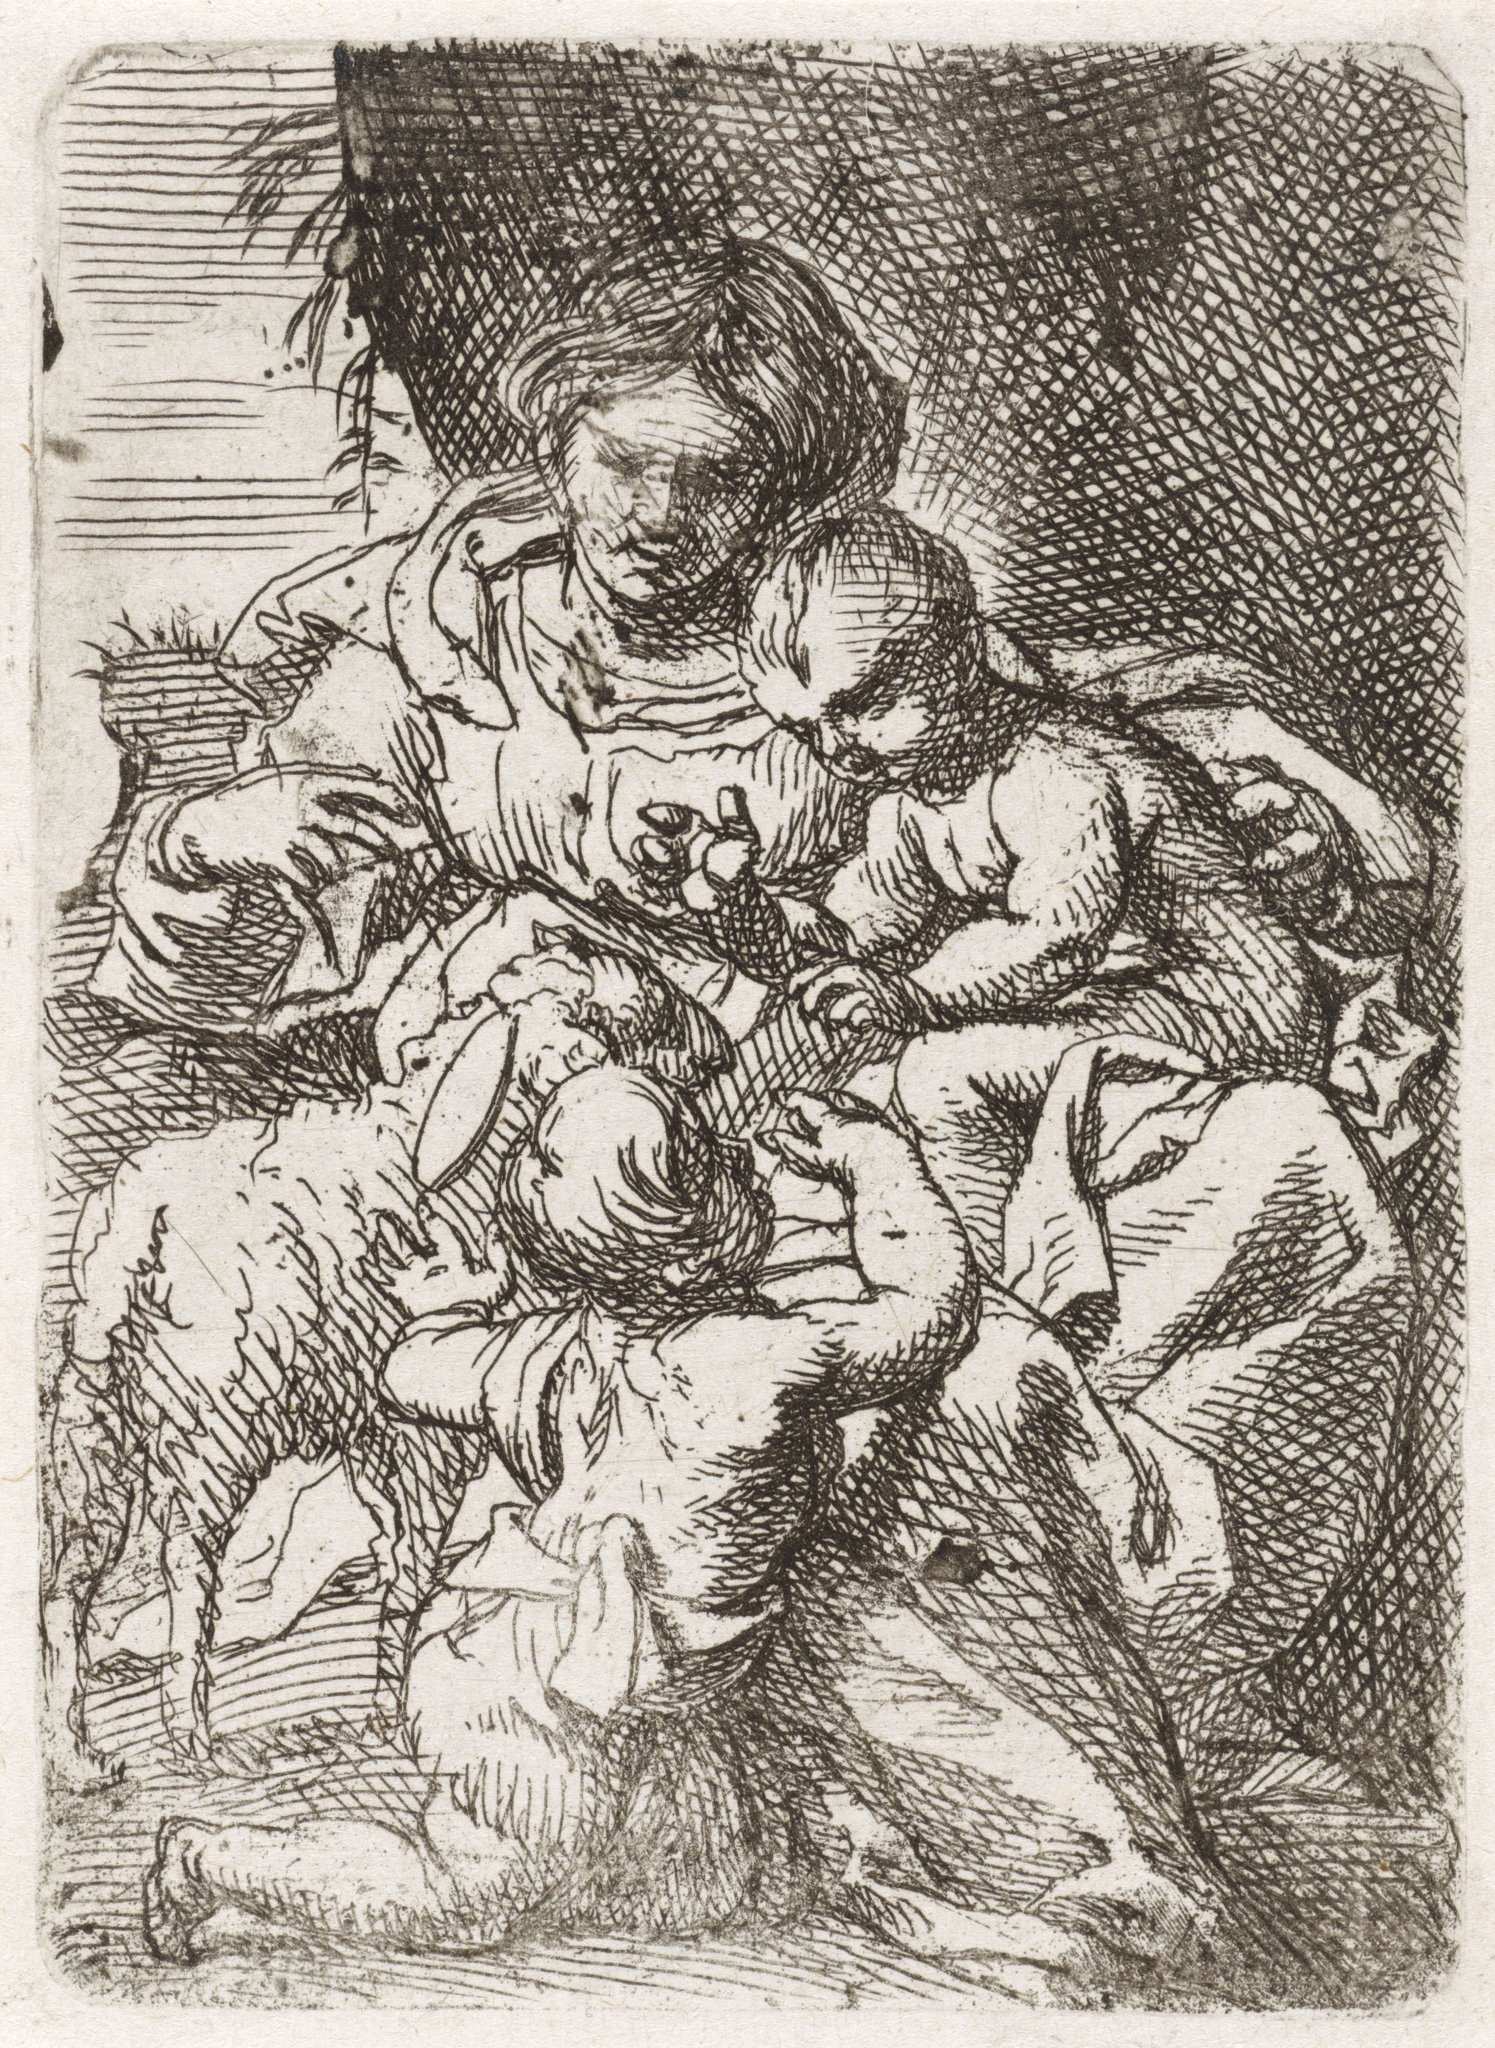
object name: print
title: Madonna met kind en Johannes de Doper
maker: cornelis schut (i)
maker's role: draughtsman, print maker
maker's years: 1597-1655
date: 1618-1655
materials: paper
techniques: etching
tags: mary and the christ-child with john the baptist (as child)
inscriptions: collector's mark: Lugt 240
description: In een landschap met een rots zit Maria op de grond. Ze kijkt naar de jonge Johannes de Doper die aan haar voeten knielt en een arm uitstrekt naar het Christuskind op haar schoot. Zijn andere hand rust op een lam naast hem.